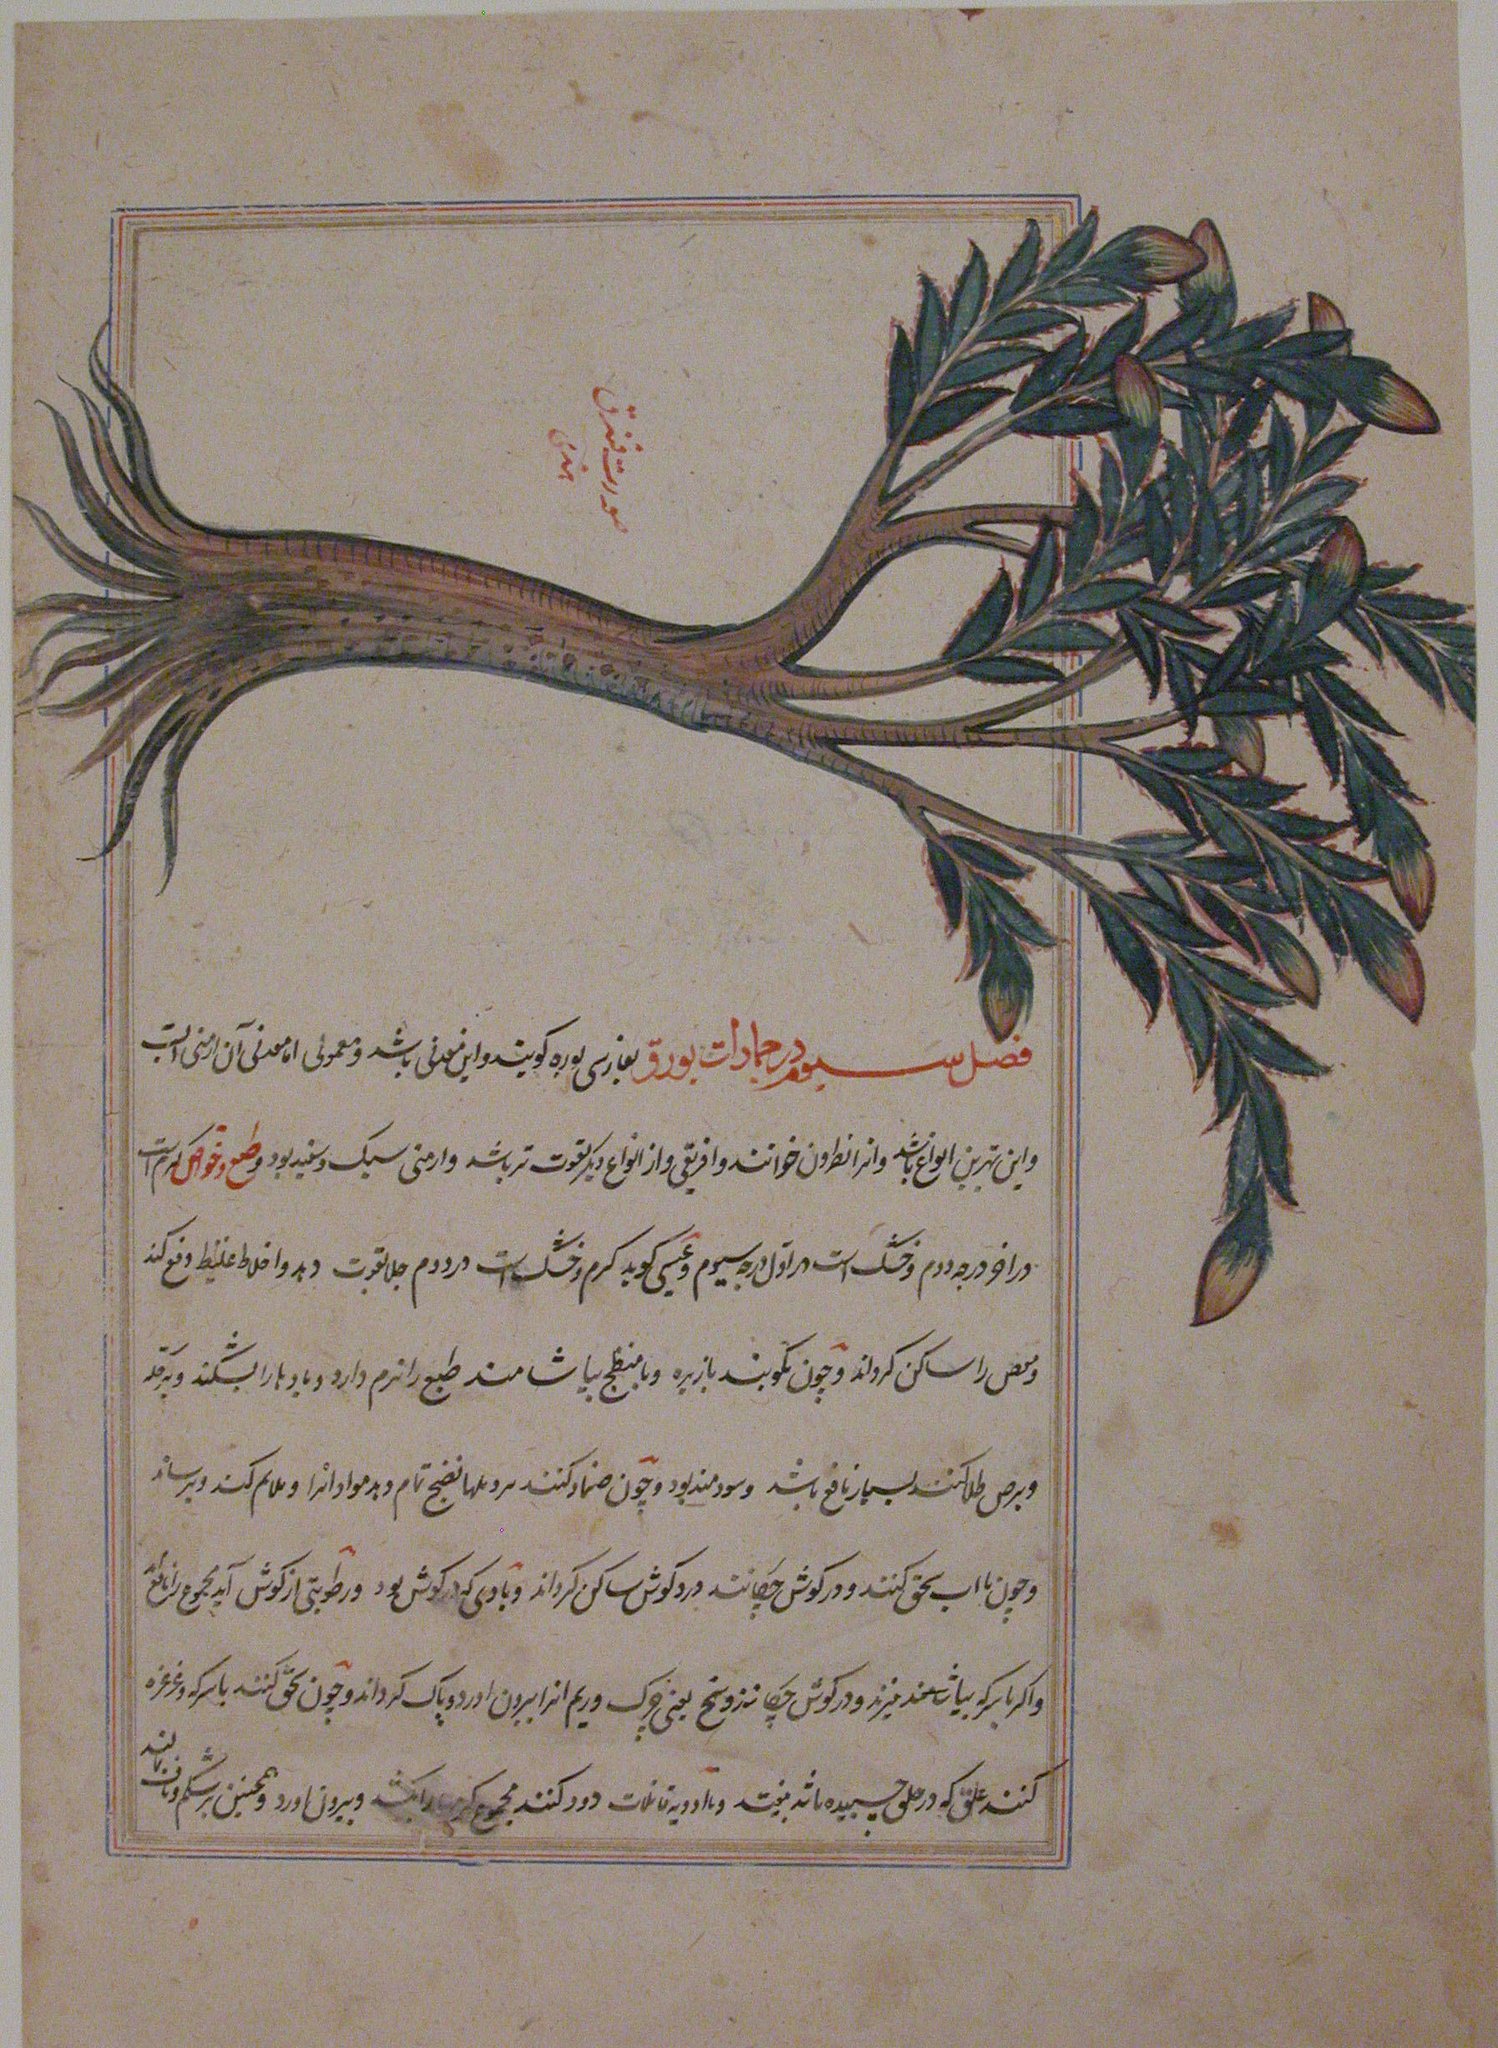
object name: folio from an illustrated manuscript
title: Folio from a Bestiary and Herbal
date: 1600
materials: gold, paper, watercolor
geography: iran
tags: trees